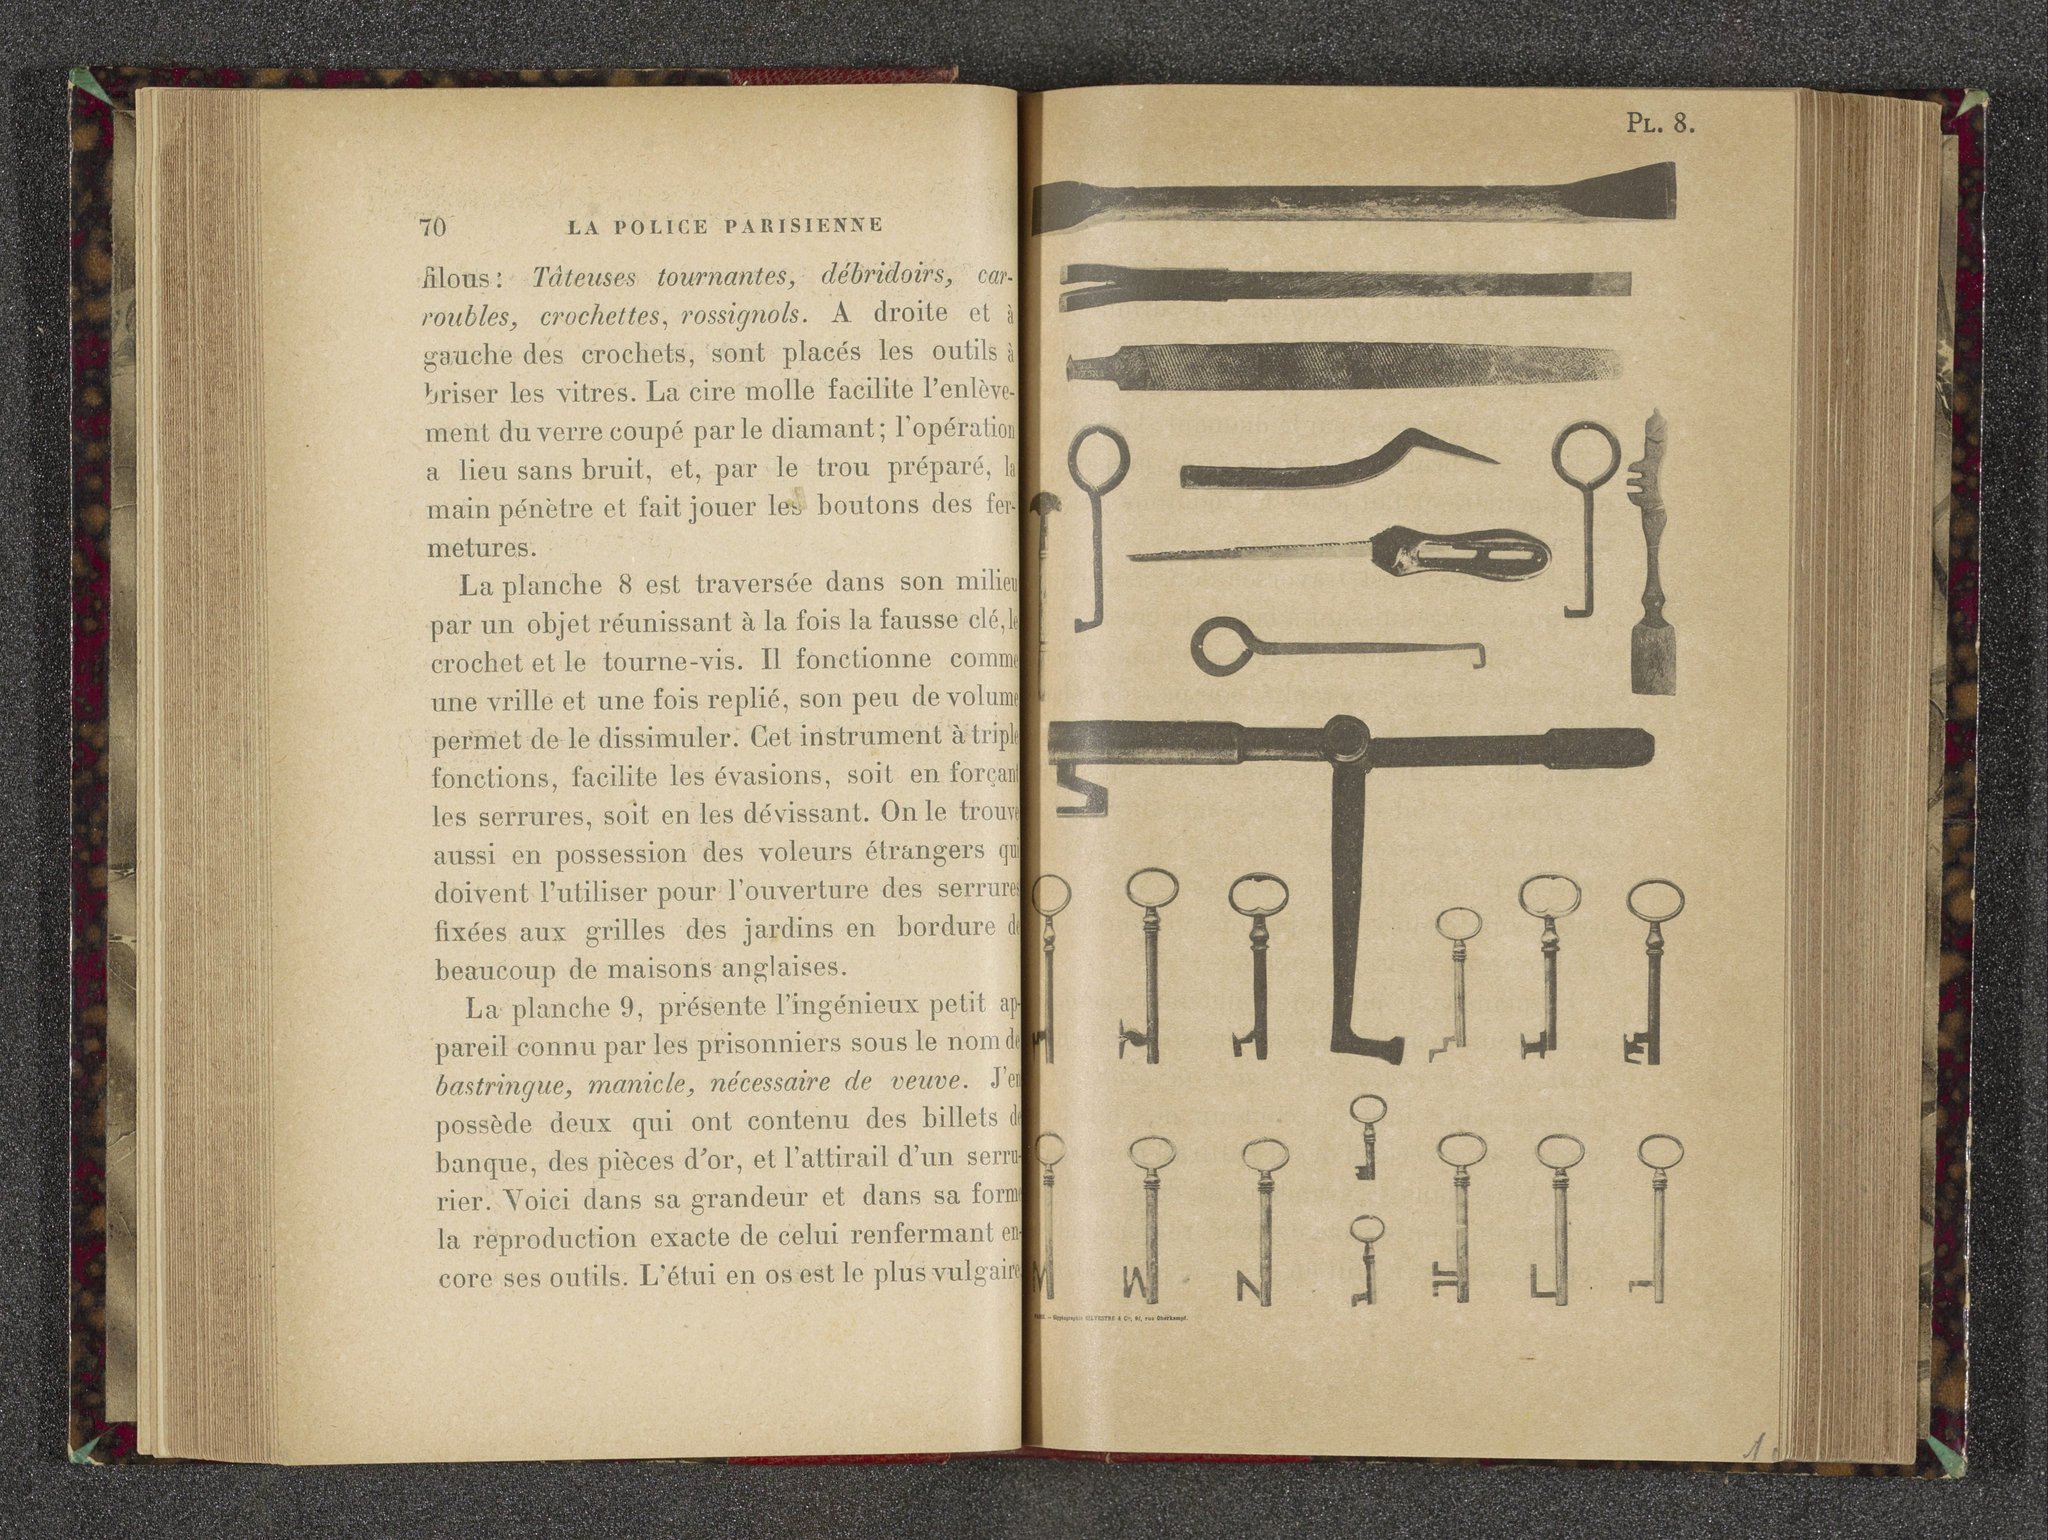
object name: photomechanical print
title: Sleutels, schroevendraaiers, haken en vijlen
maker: Anonymous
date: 1880-1890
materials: paper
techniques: photograph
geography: paris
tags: tools ~ criminals, key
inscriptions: number: ‘Pl. 8.’